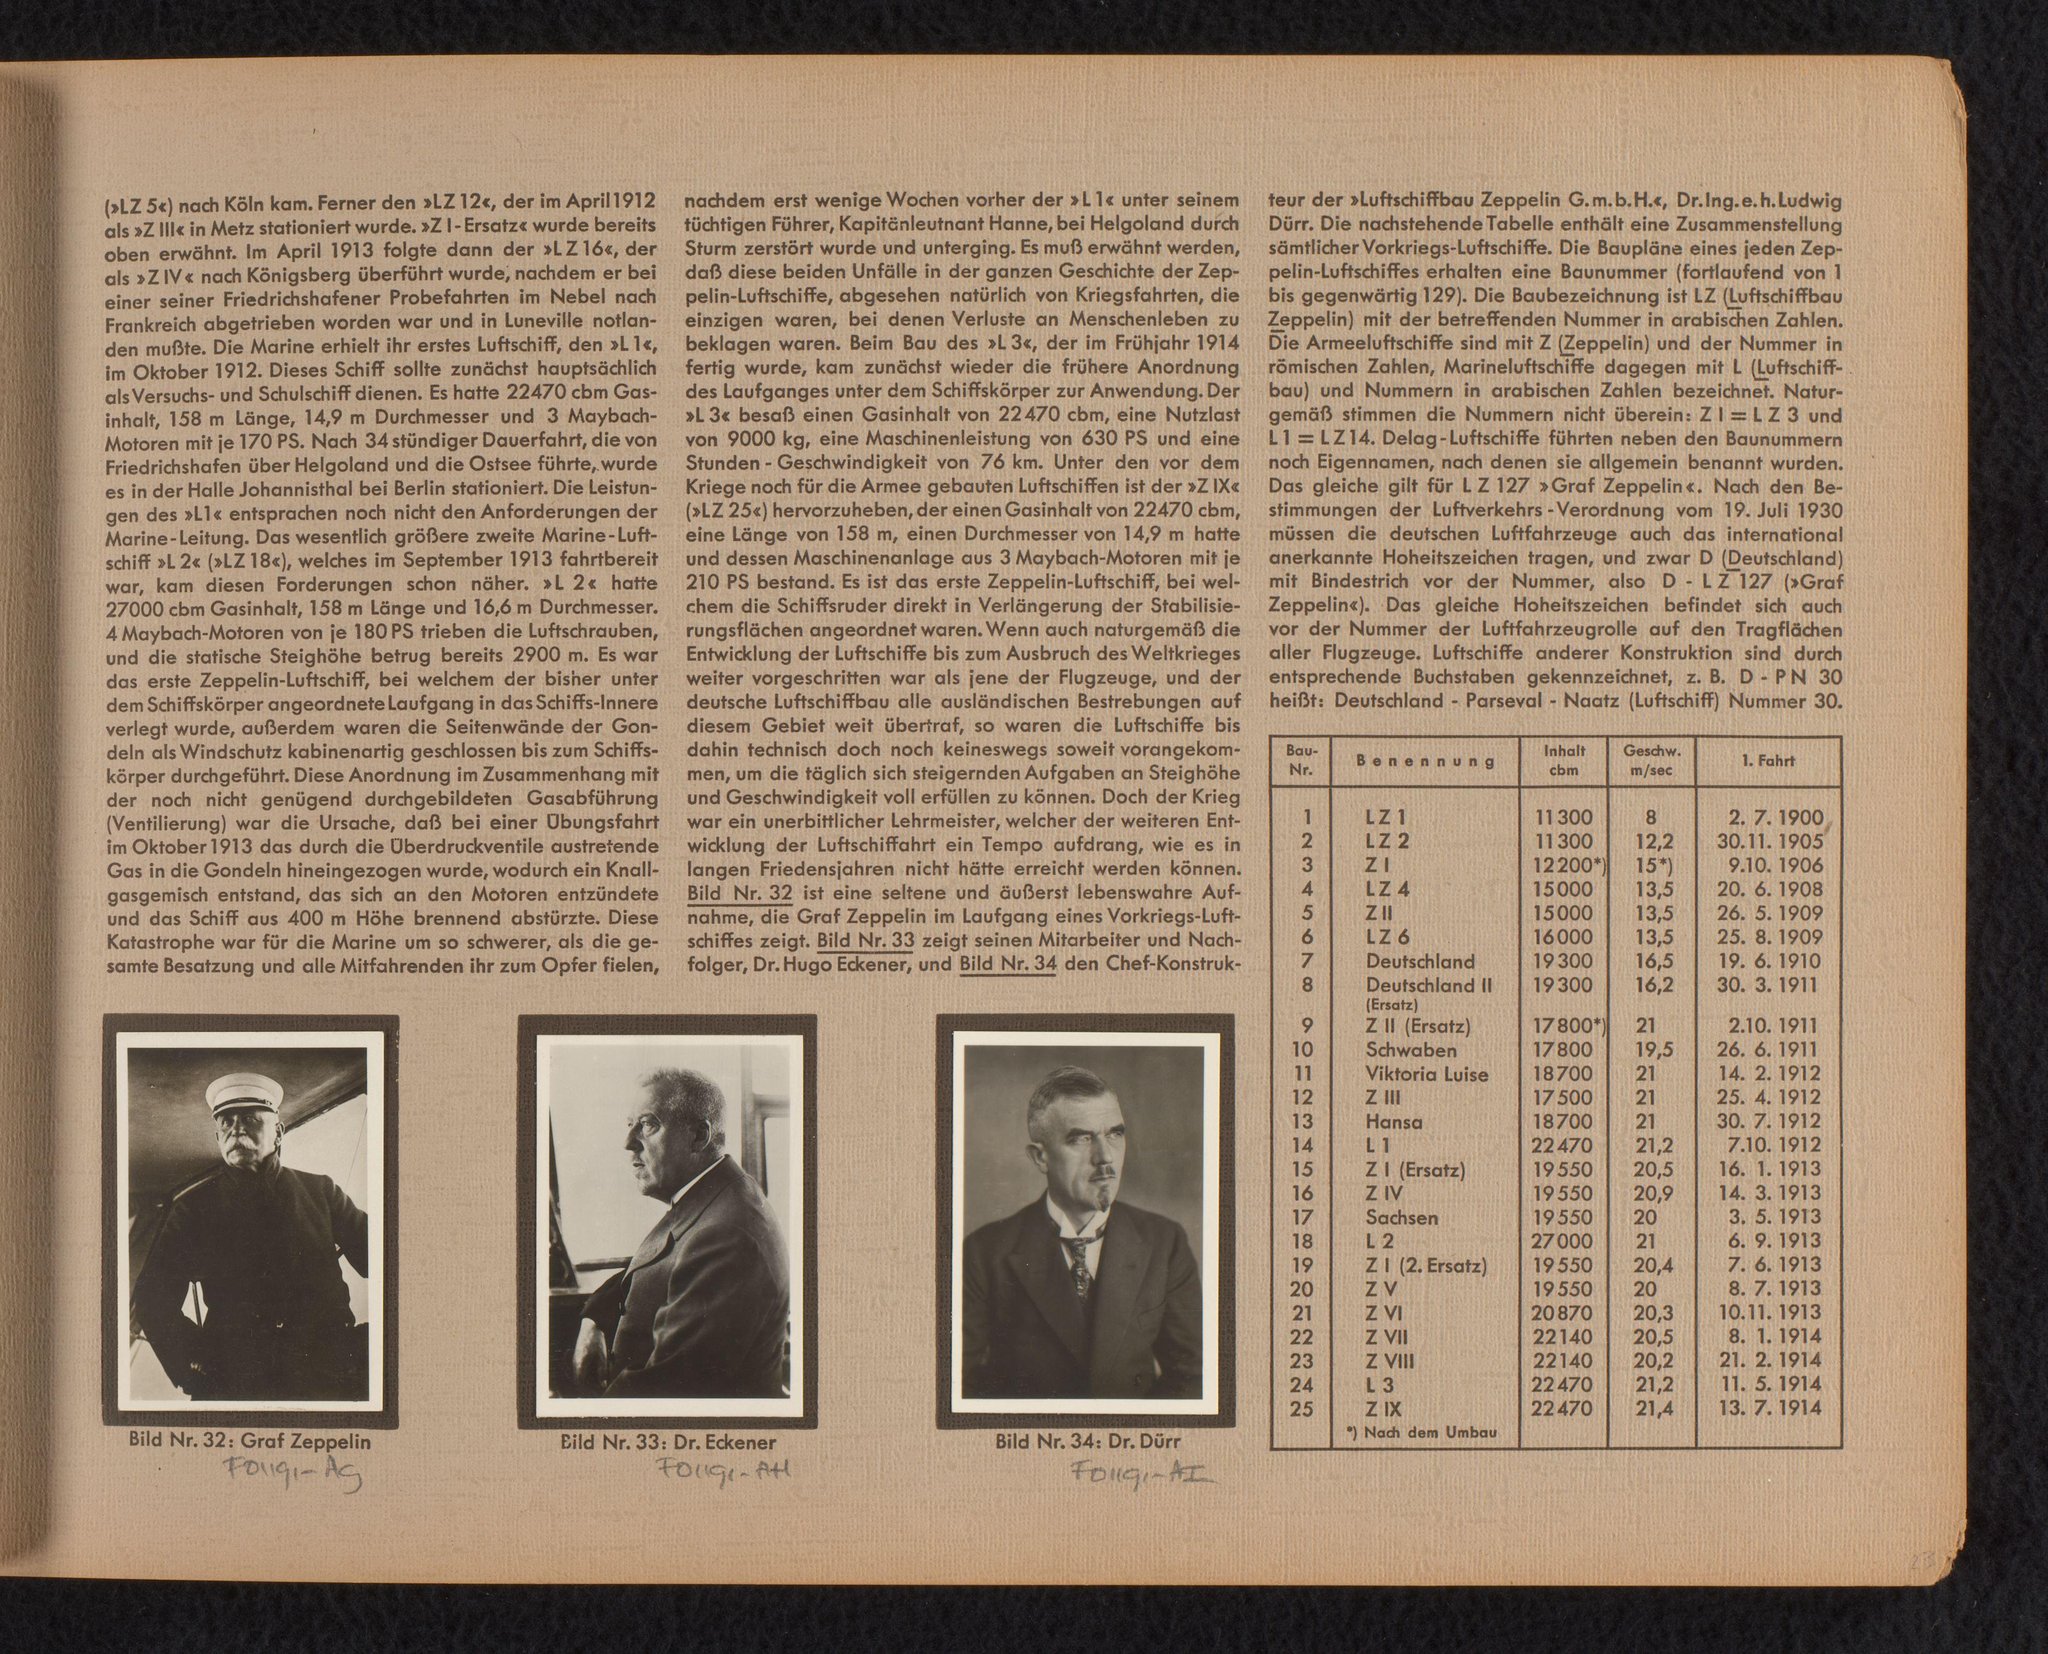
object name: photograph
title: Portretten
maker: Anonymous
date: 1912-1915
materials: paper, photographic support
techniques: gelatin silver print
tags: 46c35 airship, zeppelin, historical persons, germany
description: Pagina met drie portretten. Geportretteerd zijn Graf Zeppelin, Dr. Eckener en Dr. Dür. Alle foto's zijn voorzien van een nummer en titel. Deze pagina maakt deel uit van een album.